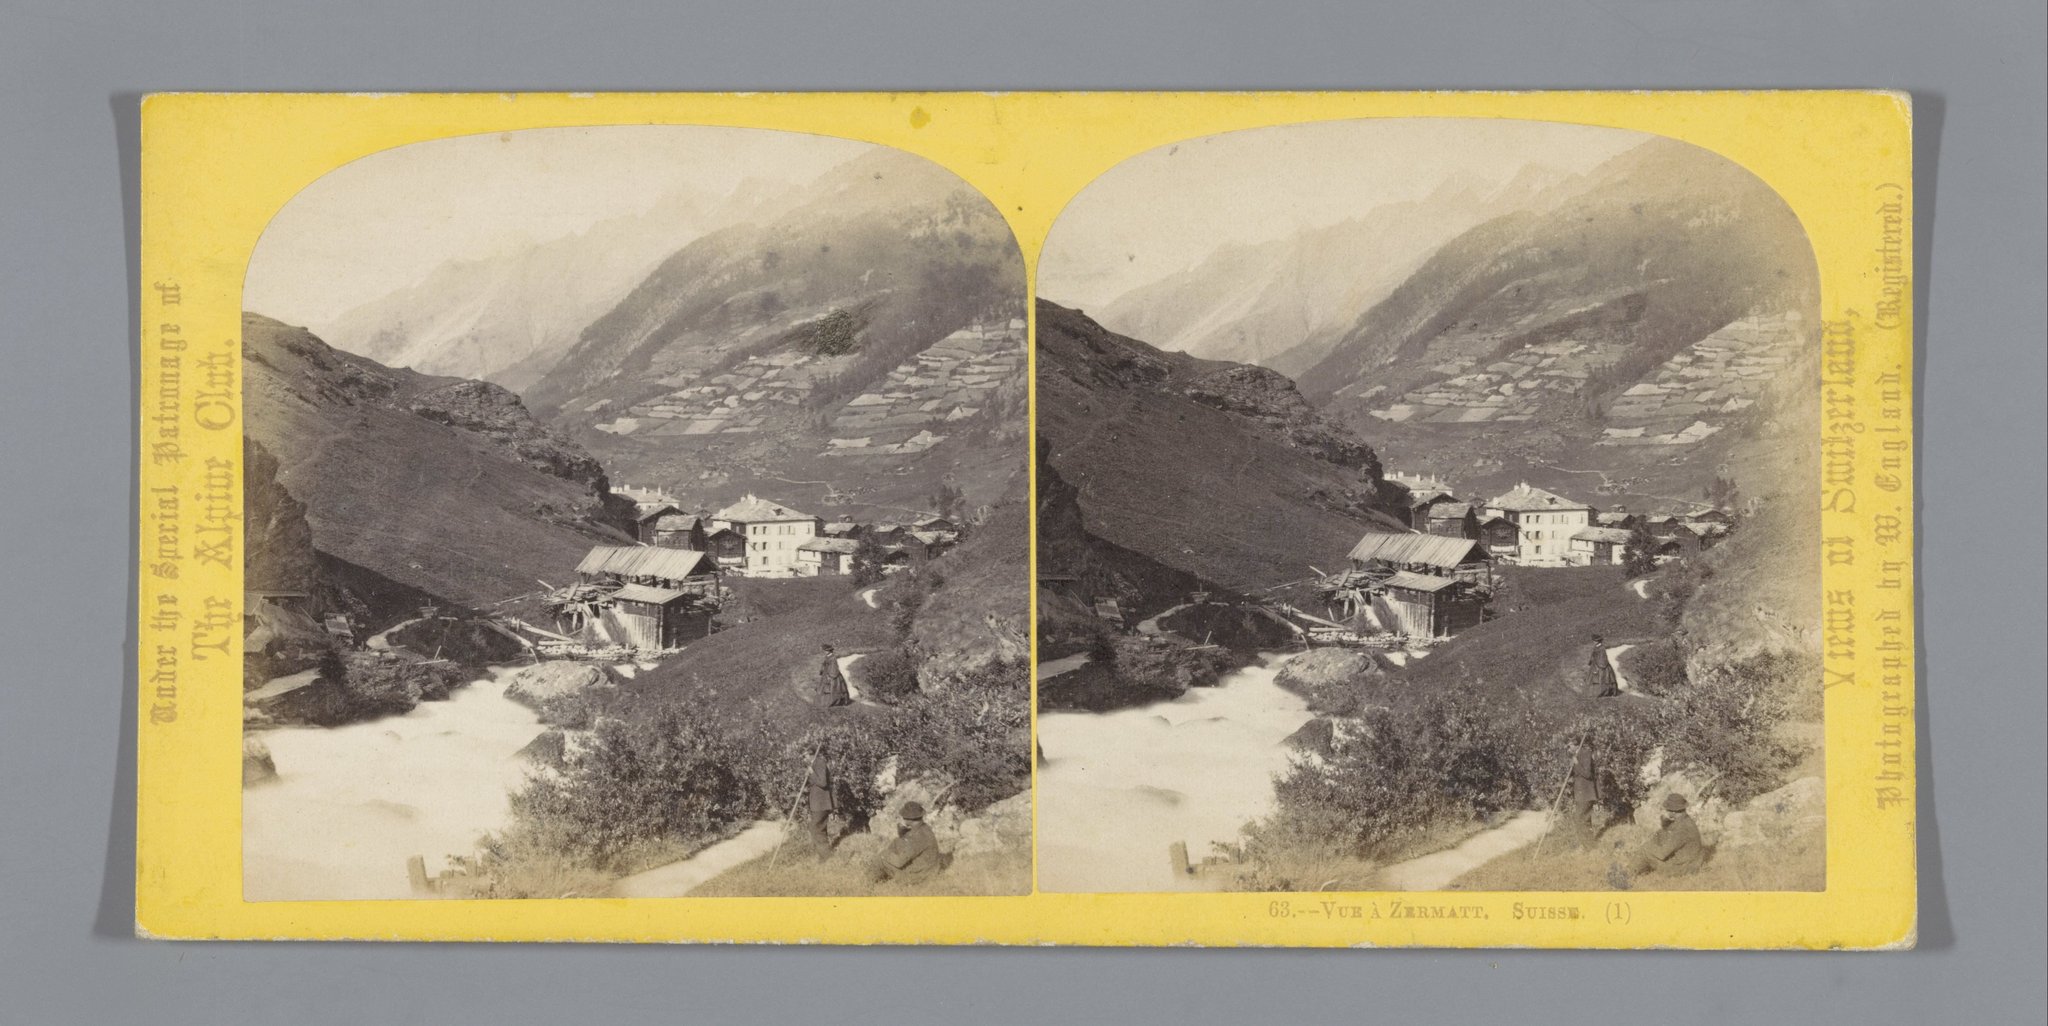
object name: stereograph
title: Vue a Zermatt. Suisse. (1)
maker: william england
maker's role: fotograaf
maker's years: 1816-1896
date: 1850-1880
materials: cardboard, photographic support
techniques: albumen print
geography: wallis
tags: city-view in general; 'veduta', mountains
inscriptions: number: ‘63.’, inscription: ‘Views of Switzerland, photographed by W. England. (Registered) Under the Special Patronage of the Alpine Club.’